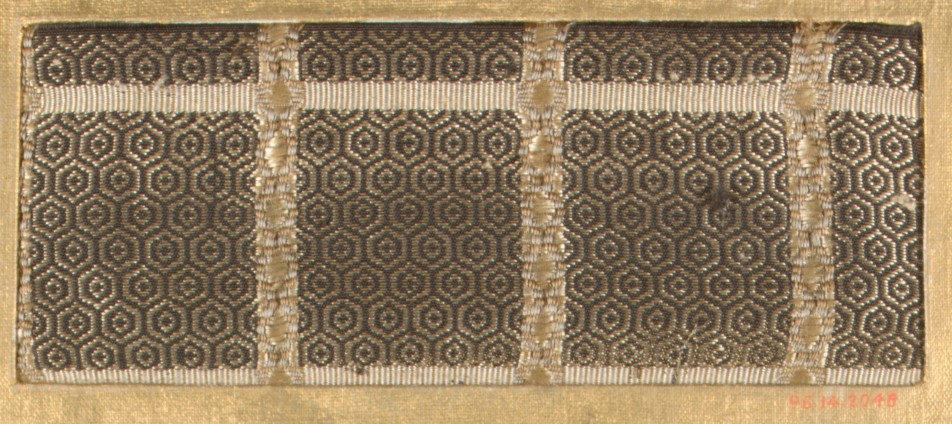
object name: piece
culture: japanese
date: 1701-1900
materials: silk